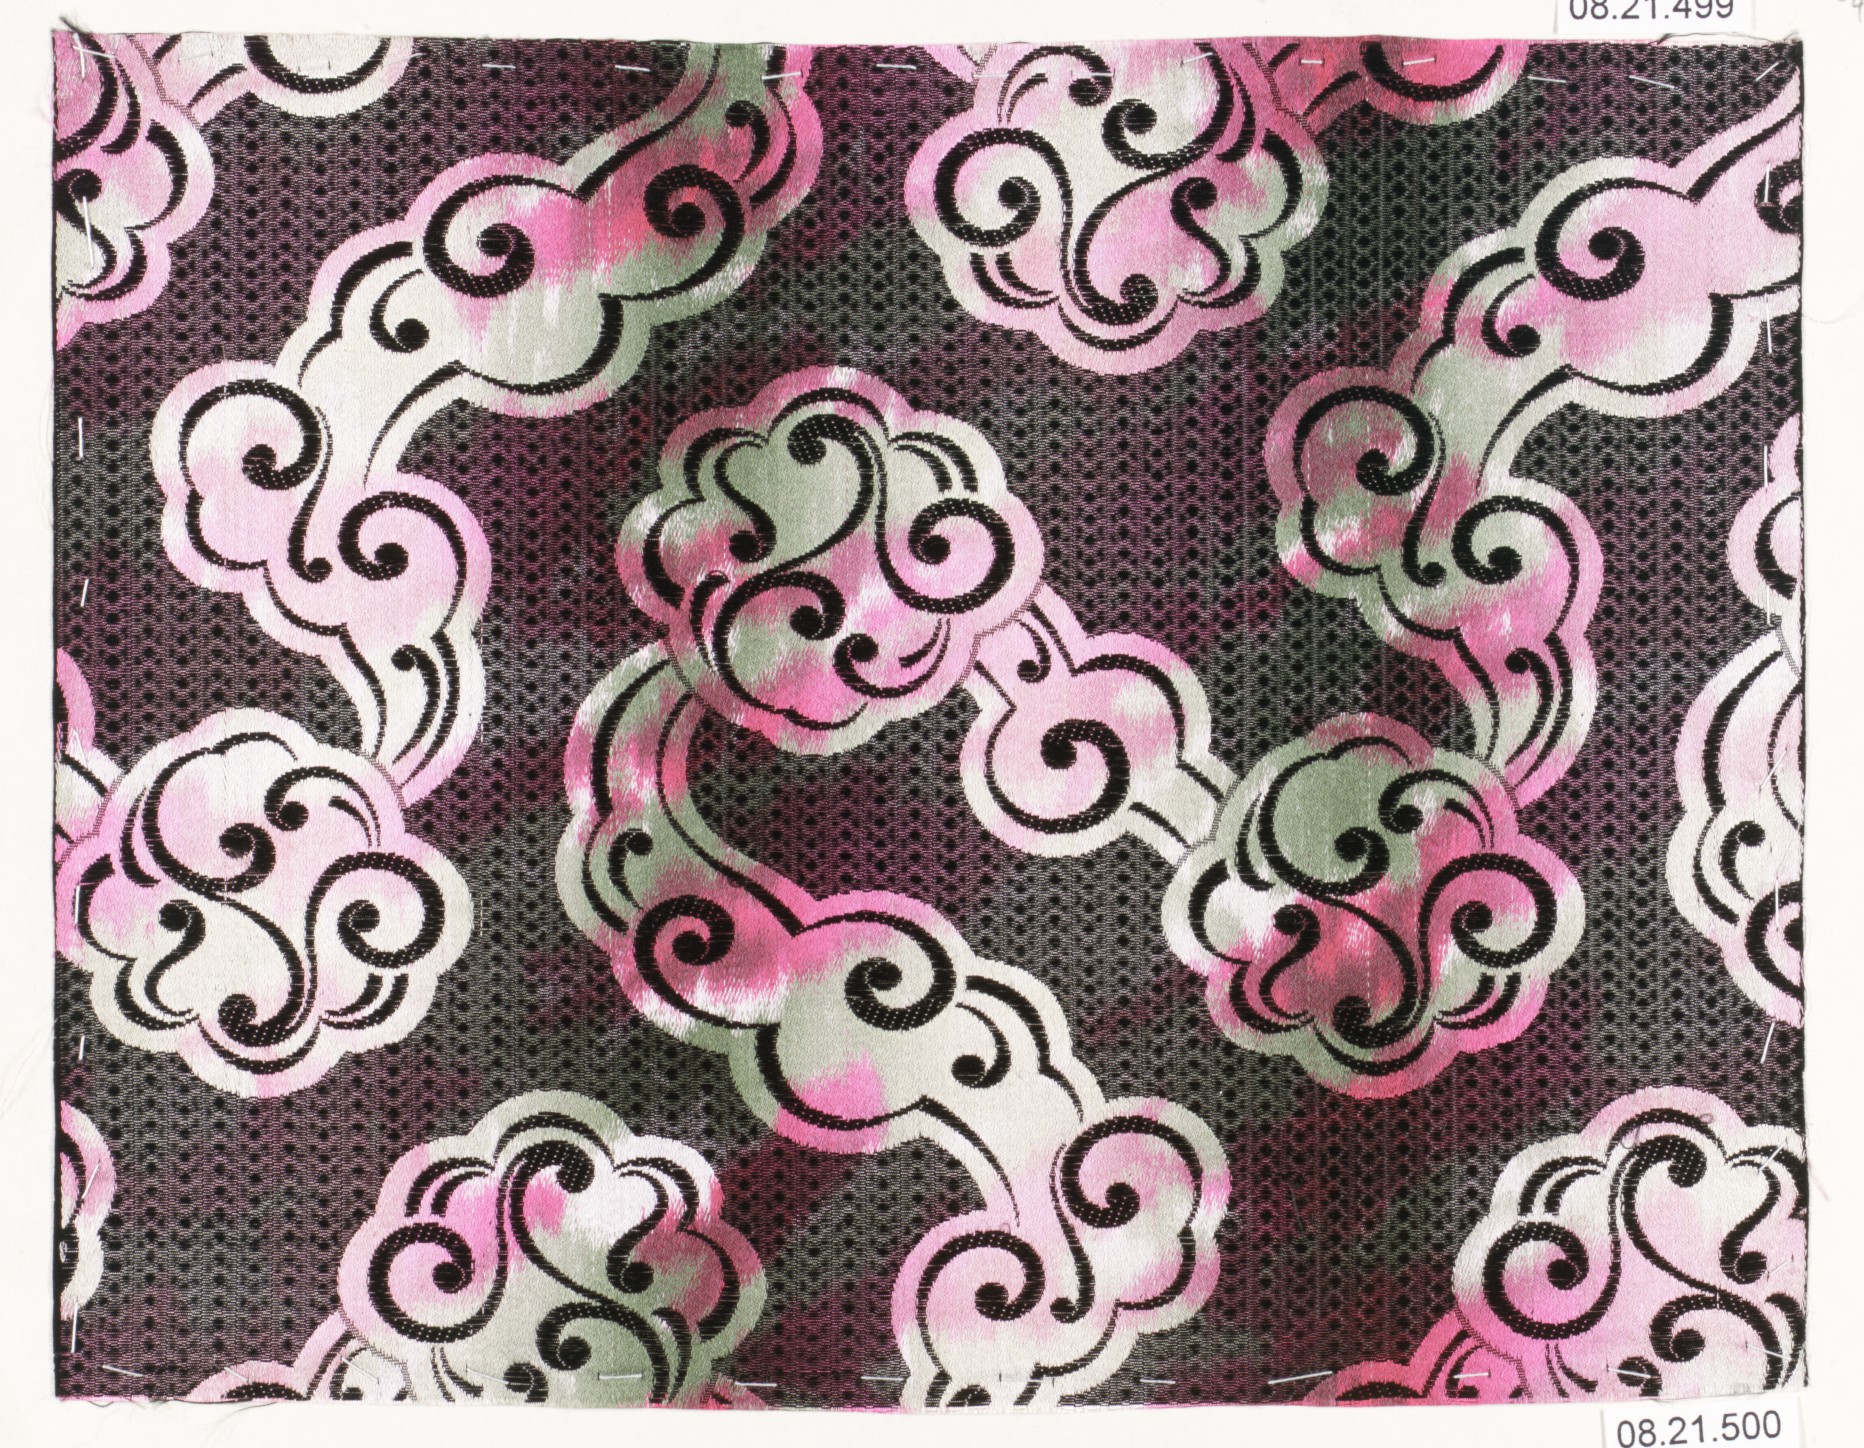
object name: textile sample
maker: Anonymous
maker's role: designer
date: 1900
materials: silk